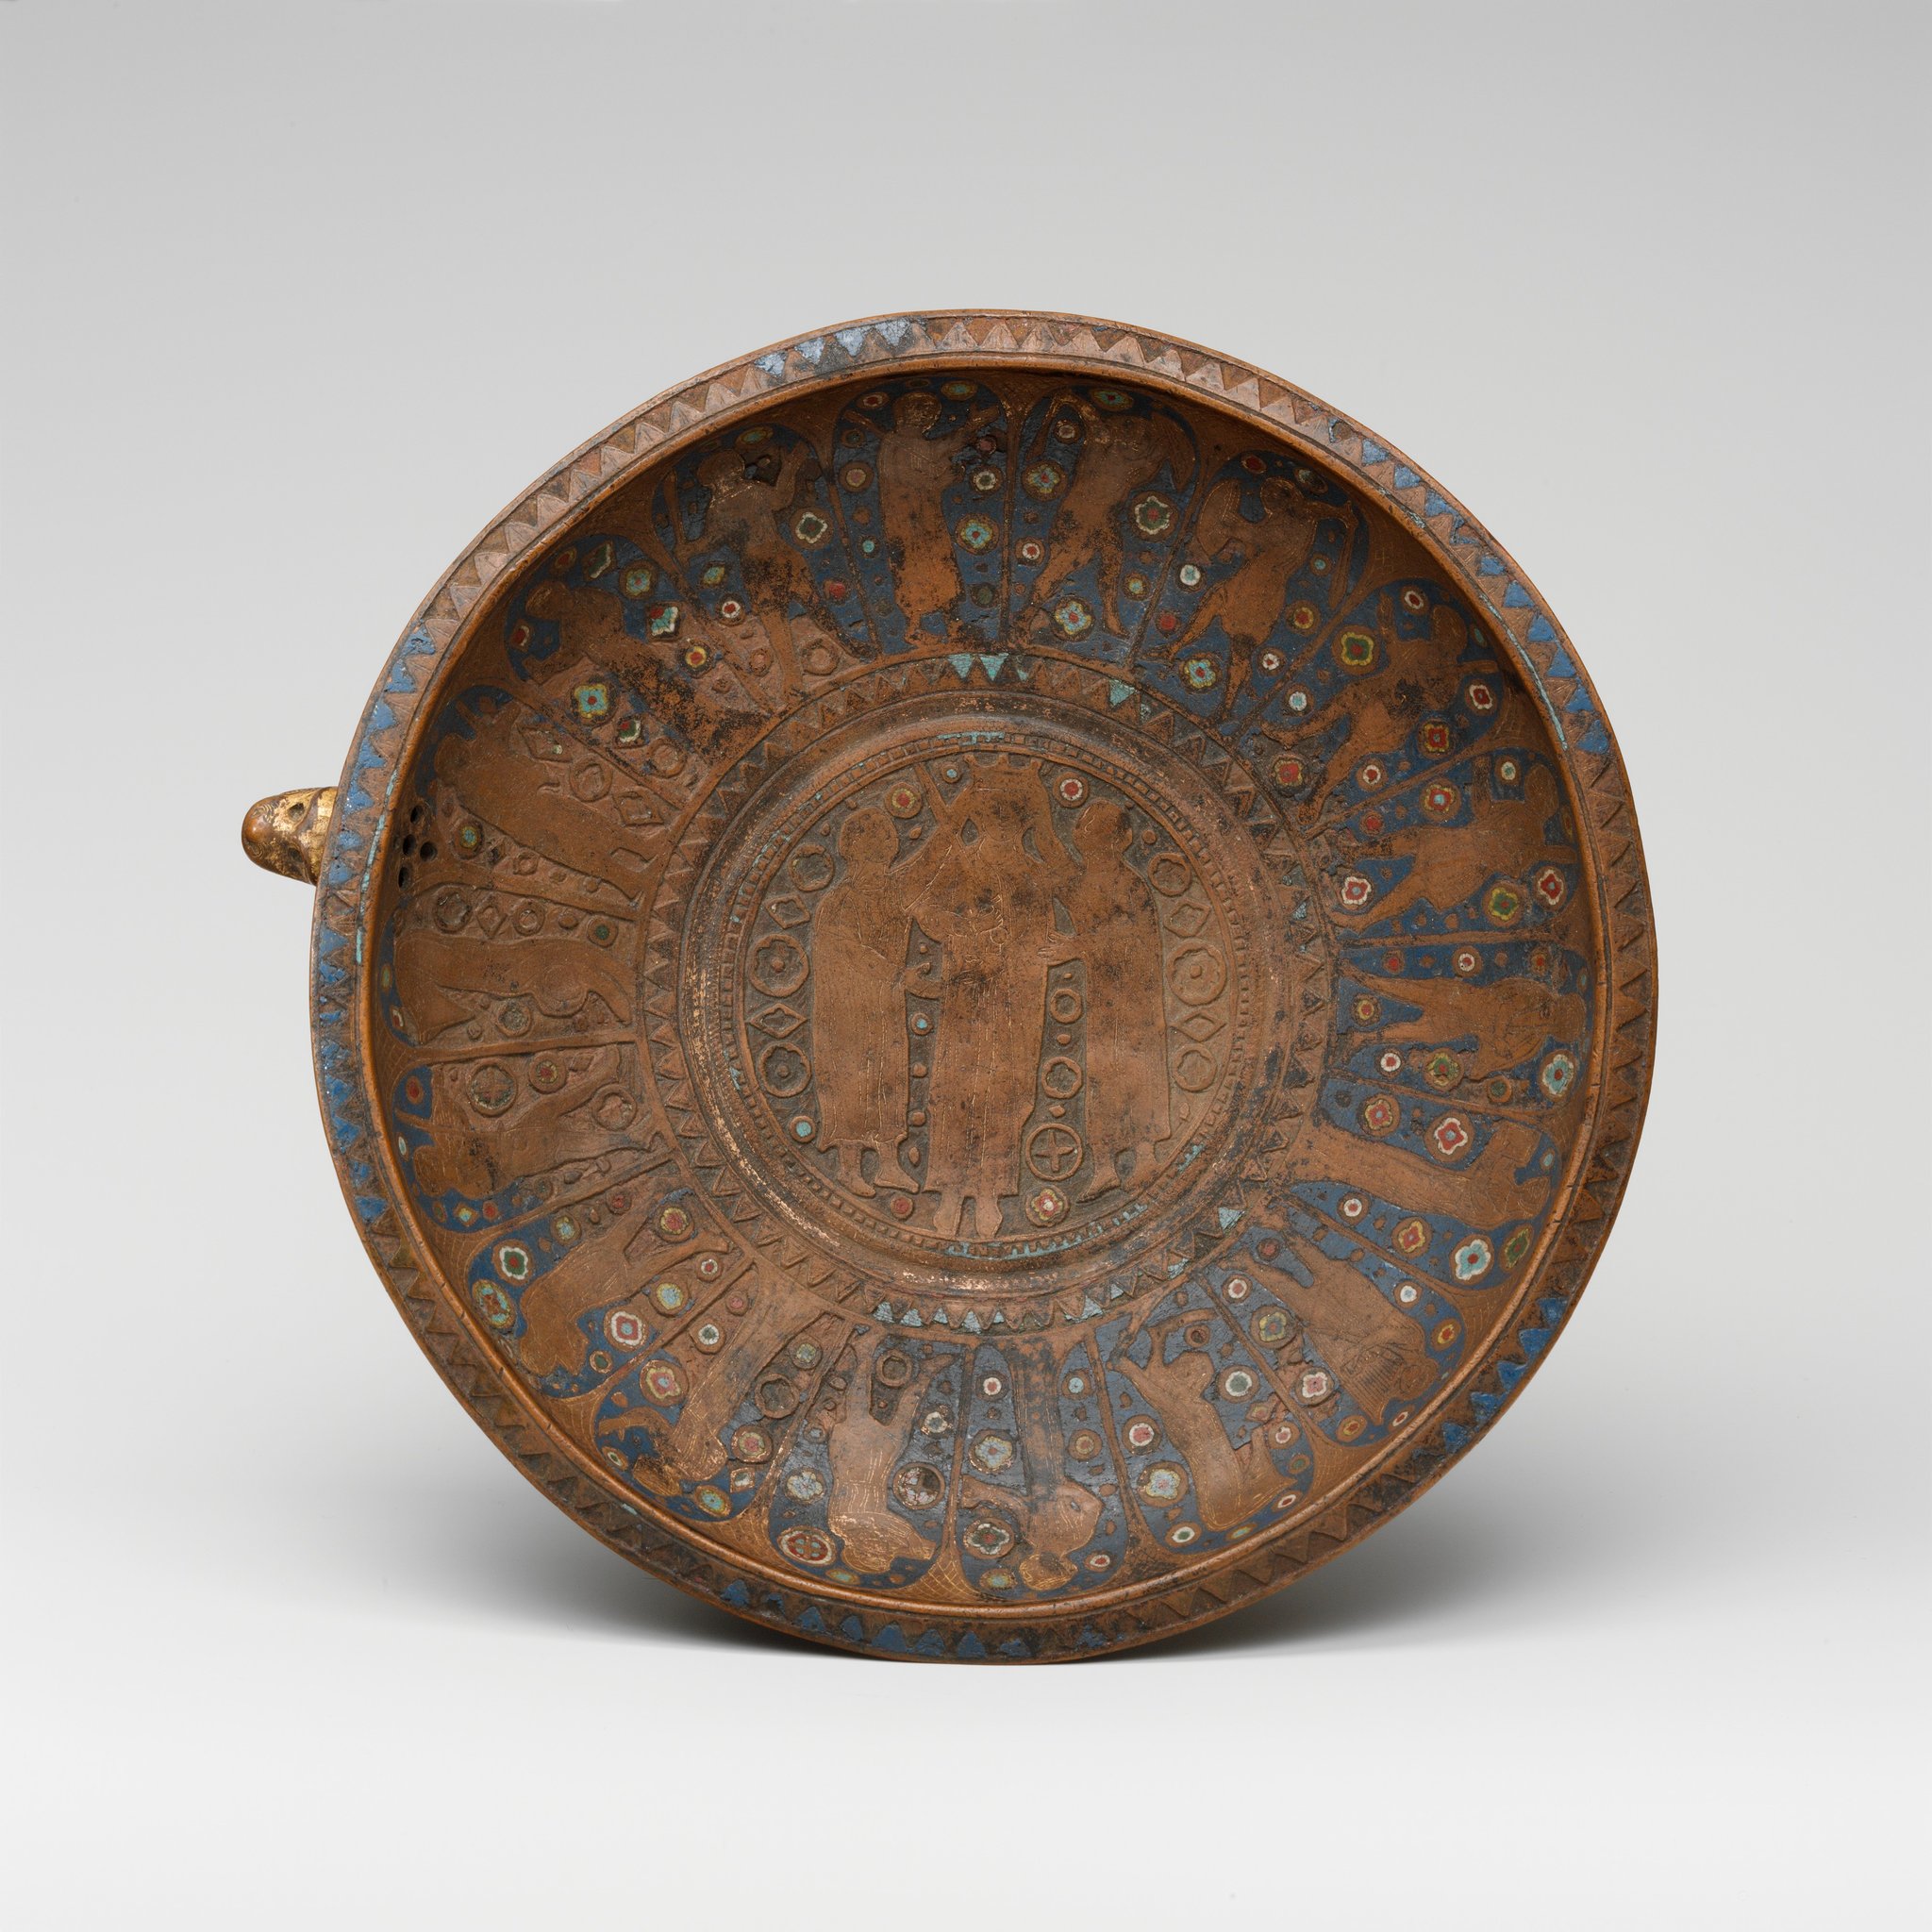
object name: gemellion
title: Gemellion with Coronation Scene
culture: french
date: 1250-1275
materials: copper, enamel, gilt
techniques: enamel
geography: france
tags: kings,men,musicians